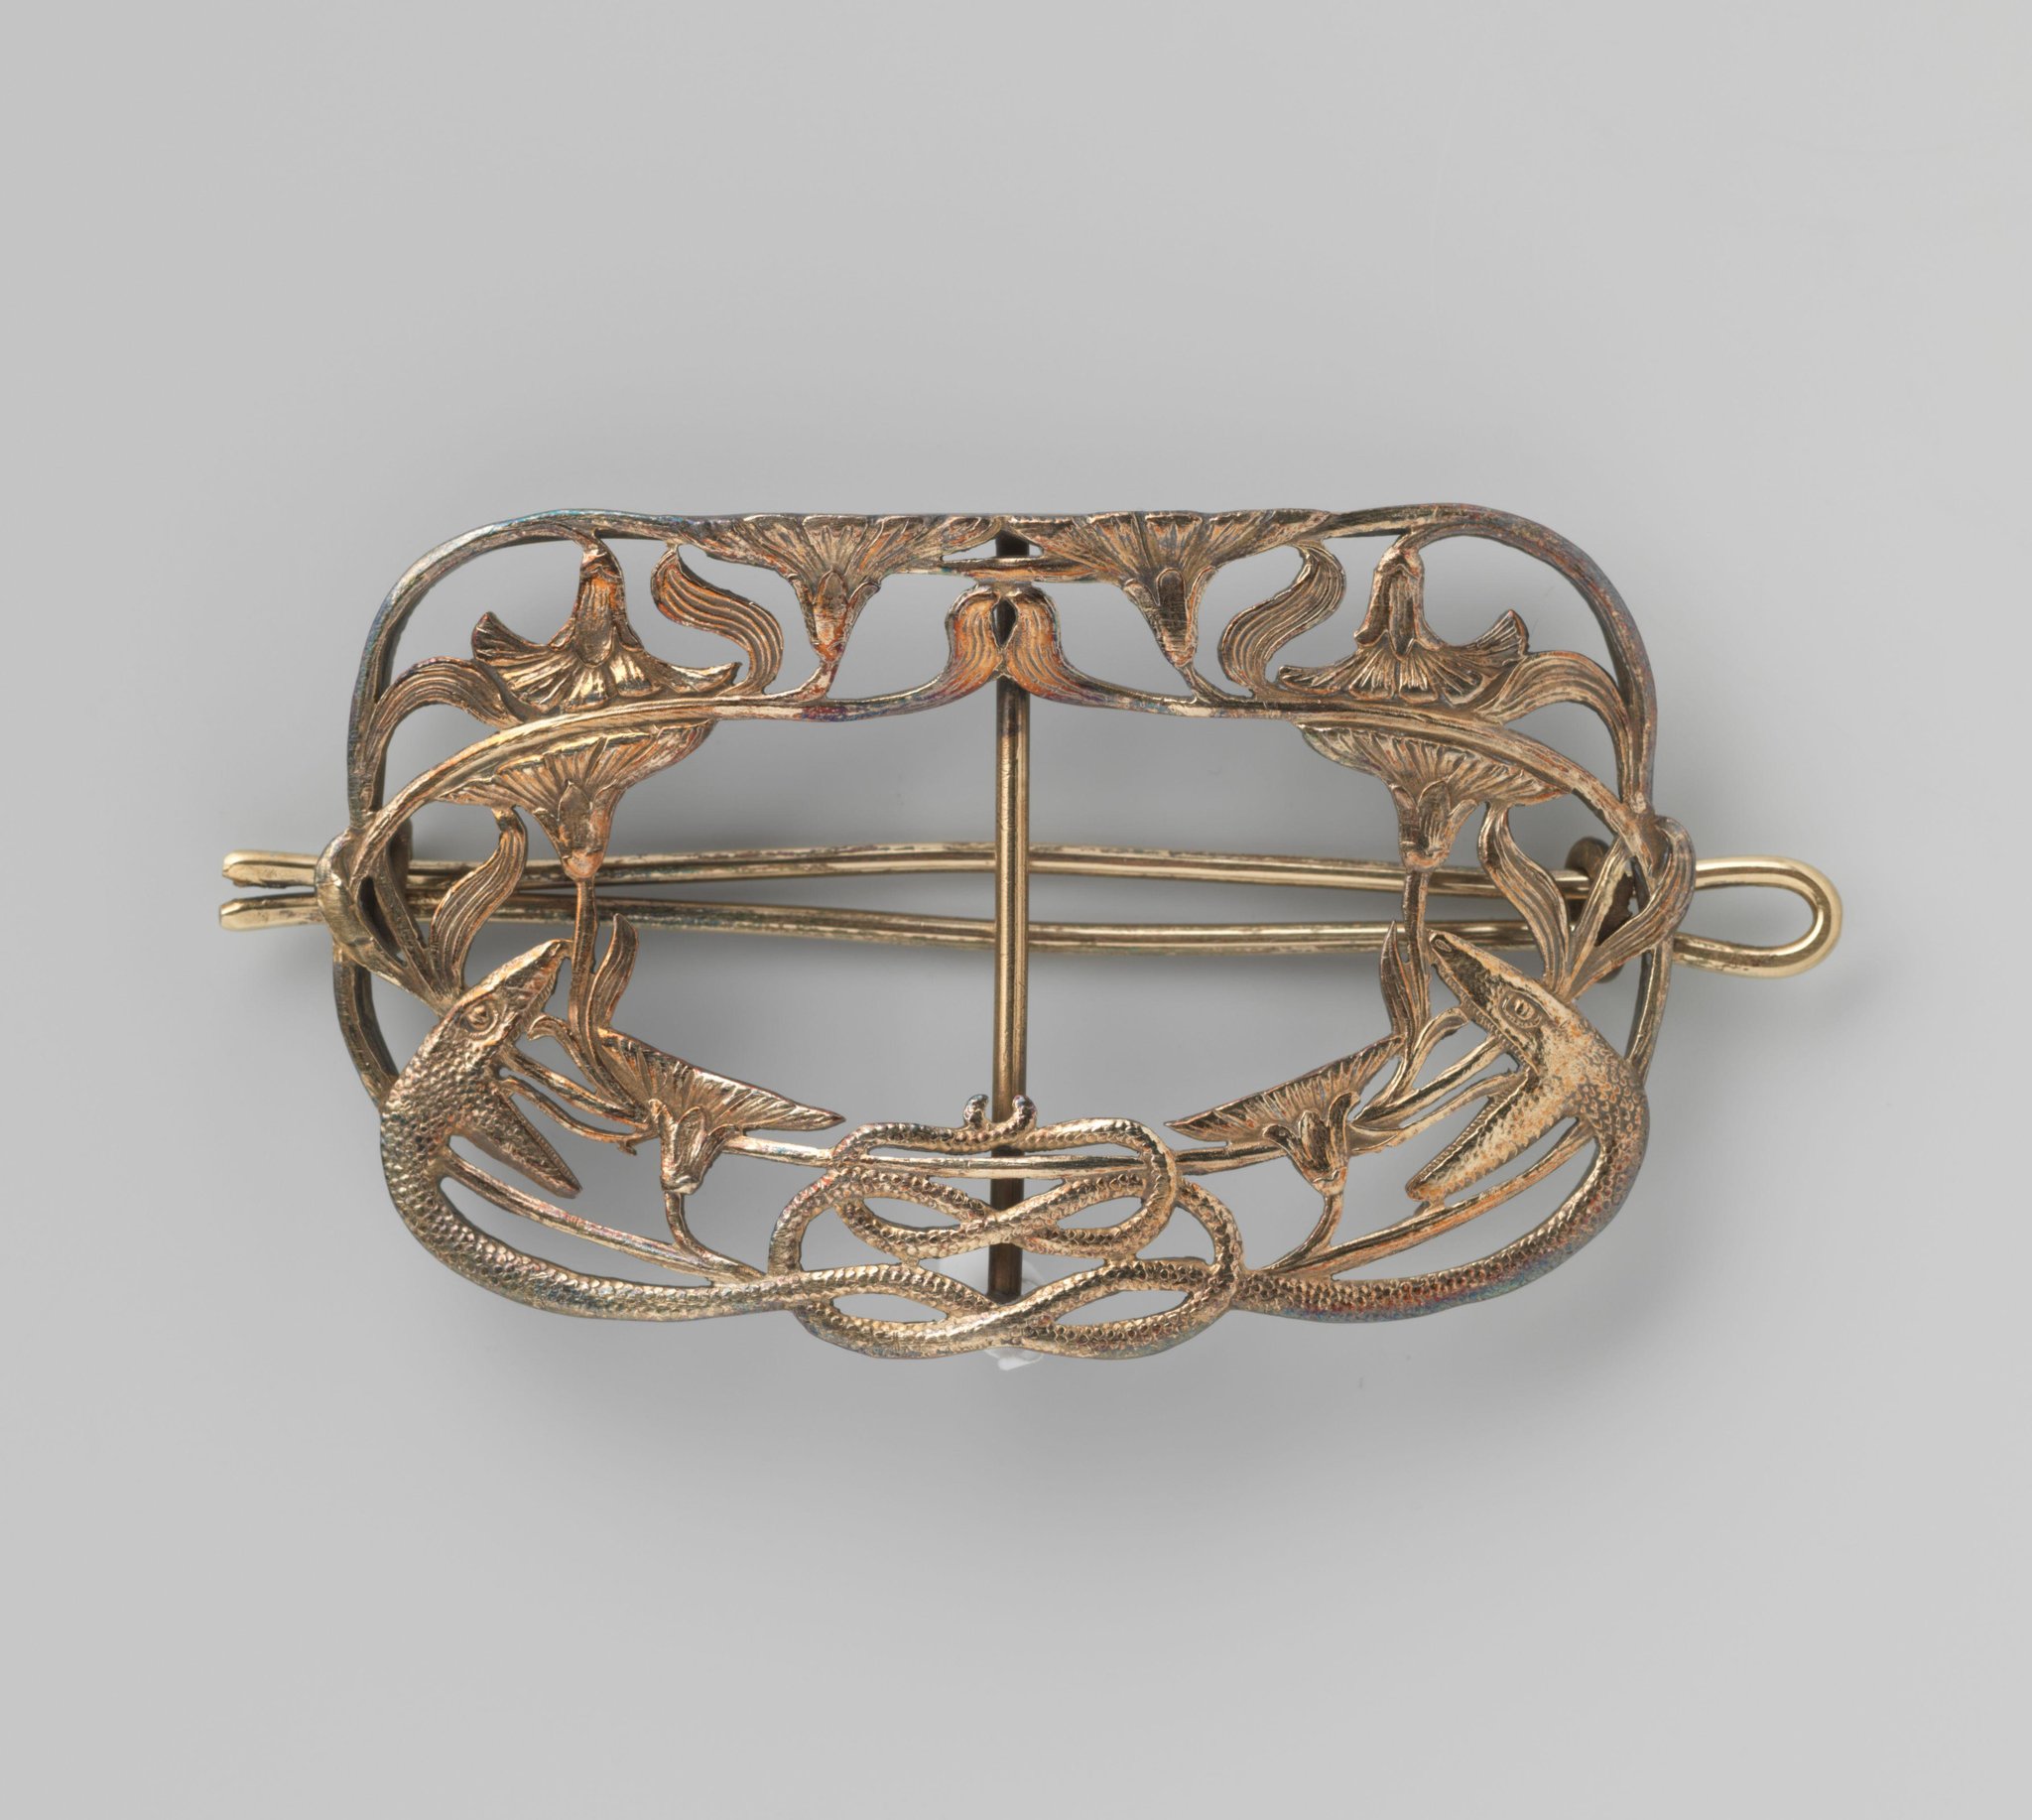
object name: jewellery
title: Gesp met slangen en bloemranken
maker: Anonymous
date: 1900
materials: silver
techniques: gilding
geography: netherlands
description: Gesp van verguld zilver. Het uitgezaagde ornament bestaat uit twee slangen met om elkaar gedraaide staarten, en bloemranken. Aan de achterzijde een uitschuifbare pin.